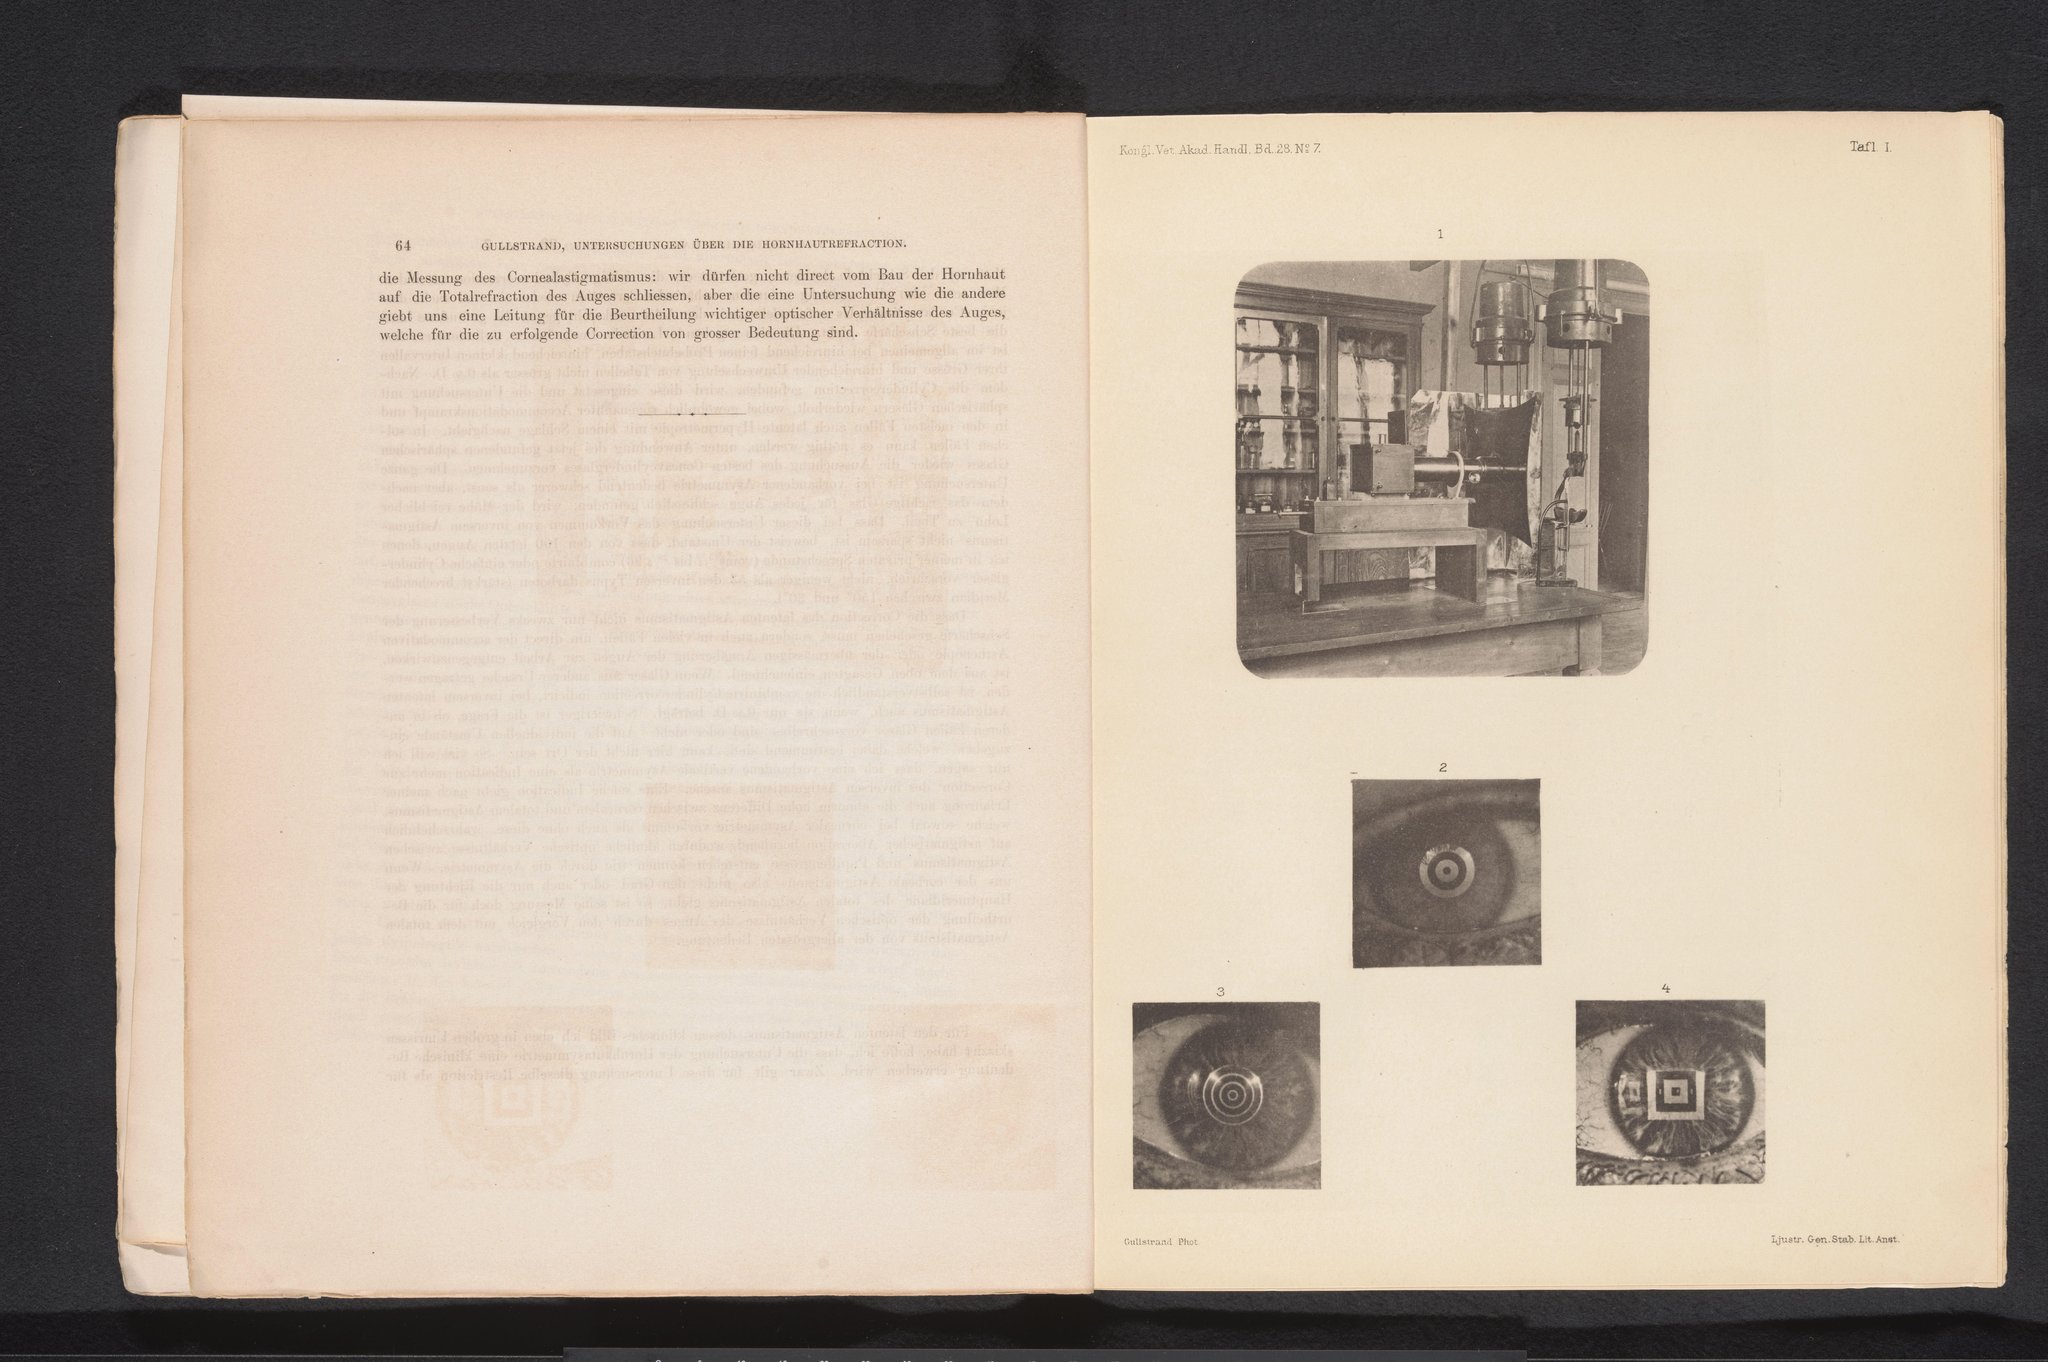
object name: photomechanical print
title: Apparaat voor oogmetingen en drie ogen met daarin vormen weerspiegeld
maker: allvar gullstrand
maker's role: arts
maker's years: 1862-1930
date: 1886-1896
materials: paper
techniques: photograph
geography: stockholm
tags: eyes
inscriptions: inscription: ‘Kongl. Vet. Akad. Handl. Bd. 28. No. 7.’, number: ‘Tafl. I. 1 2 3 4’